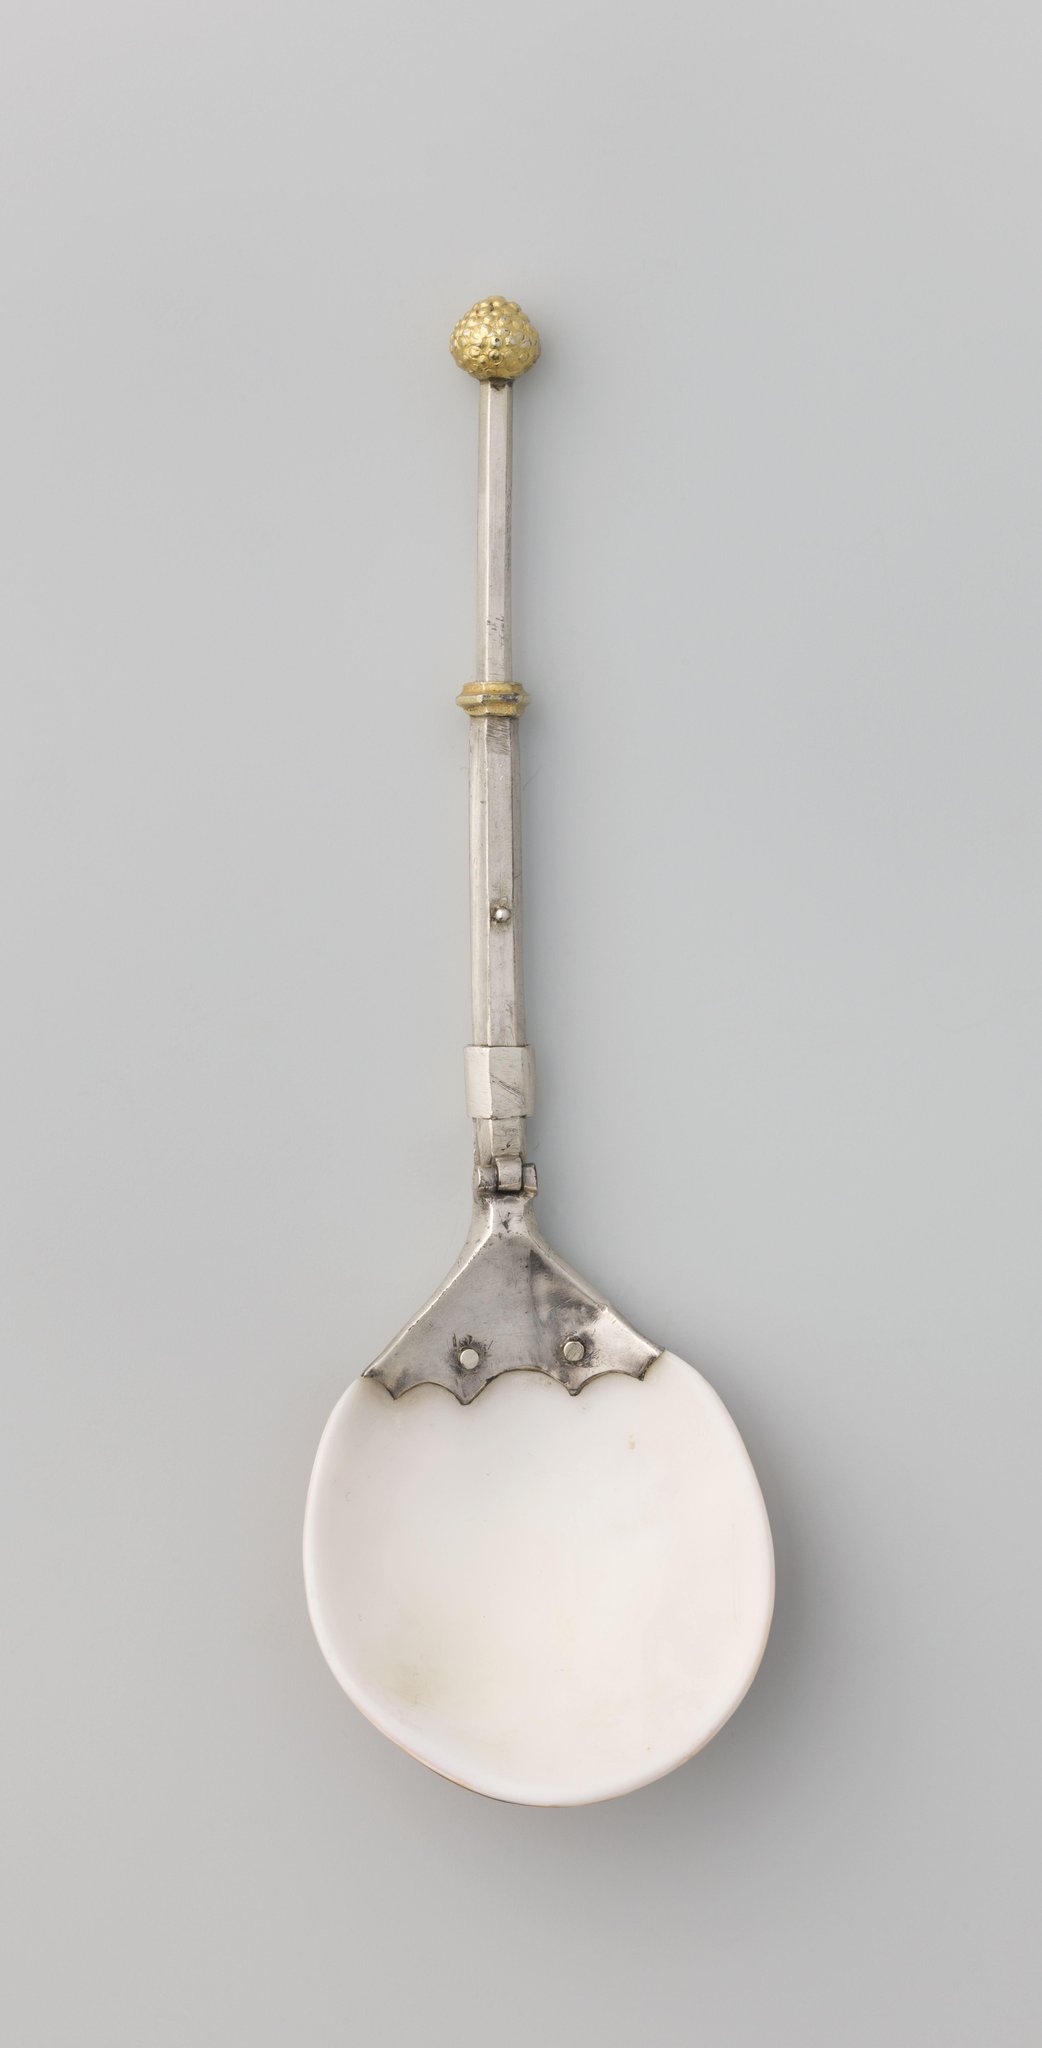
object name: spoon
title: Lepel met steel van zilver, peervormige bak van schelp. Inschuifbare steel wordt bekroond door een pijnappel.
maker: Anonymous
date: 1550-1650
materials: shell, silver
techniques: gilding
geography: north europe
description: Cornelis Bellekin. Nautilus shell with vine tendrils. Amsterdam, c. 1660 - 1700. Folding spoon. Shell and partly gilded silver. Netherlands (?), c. 1550 - 1600.